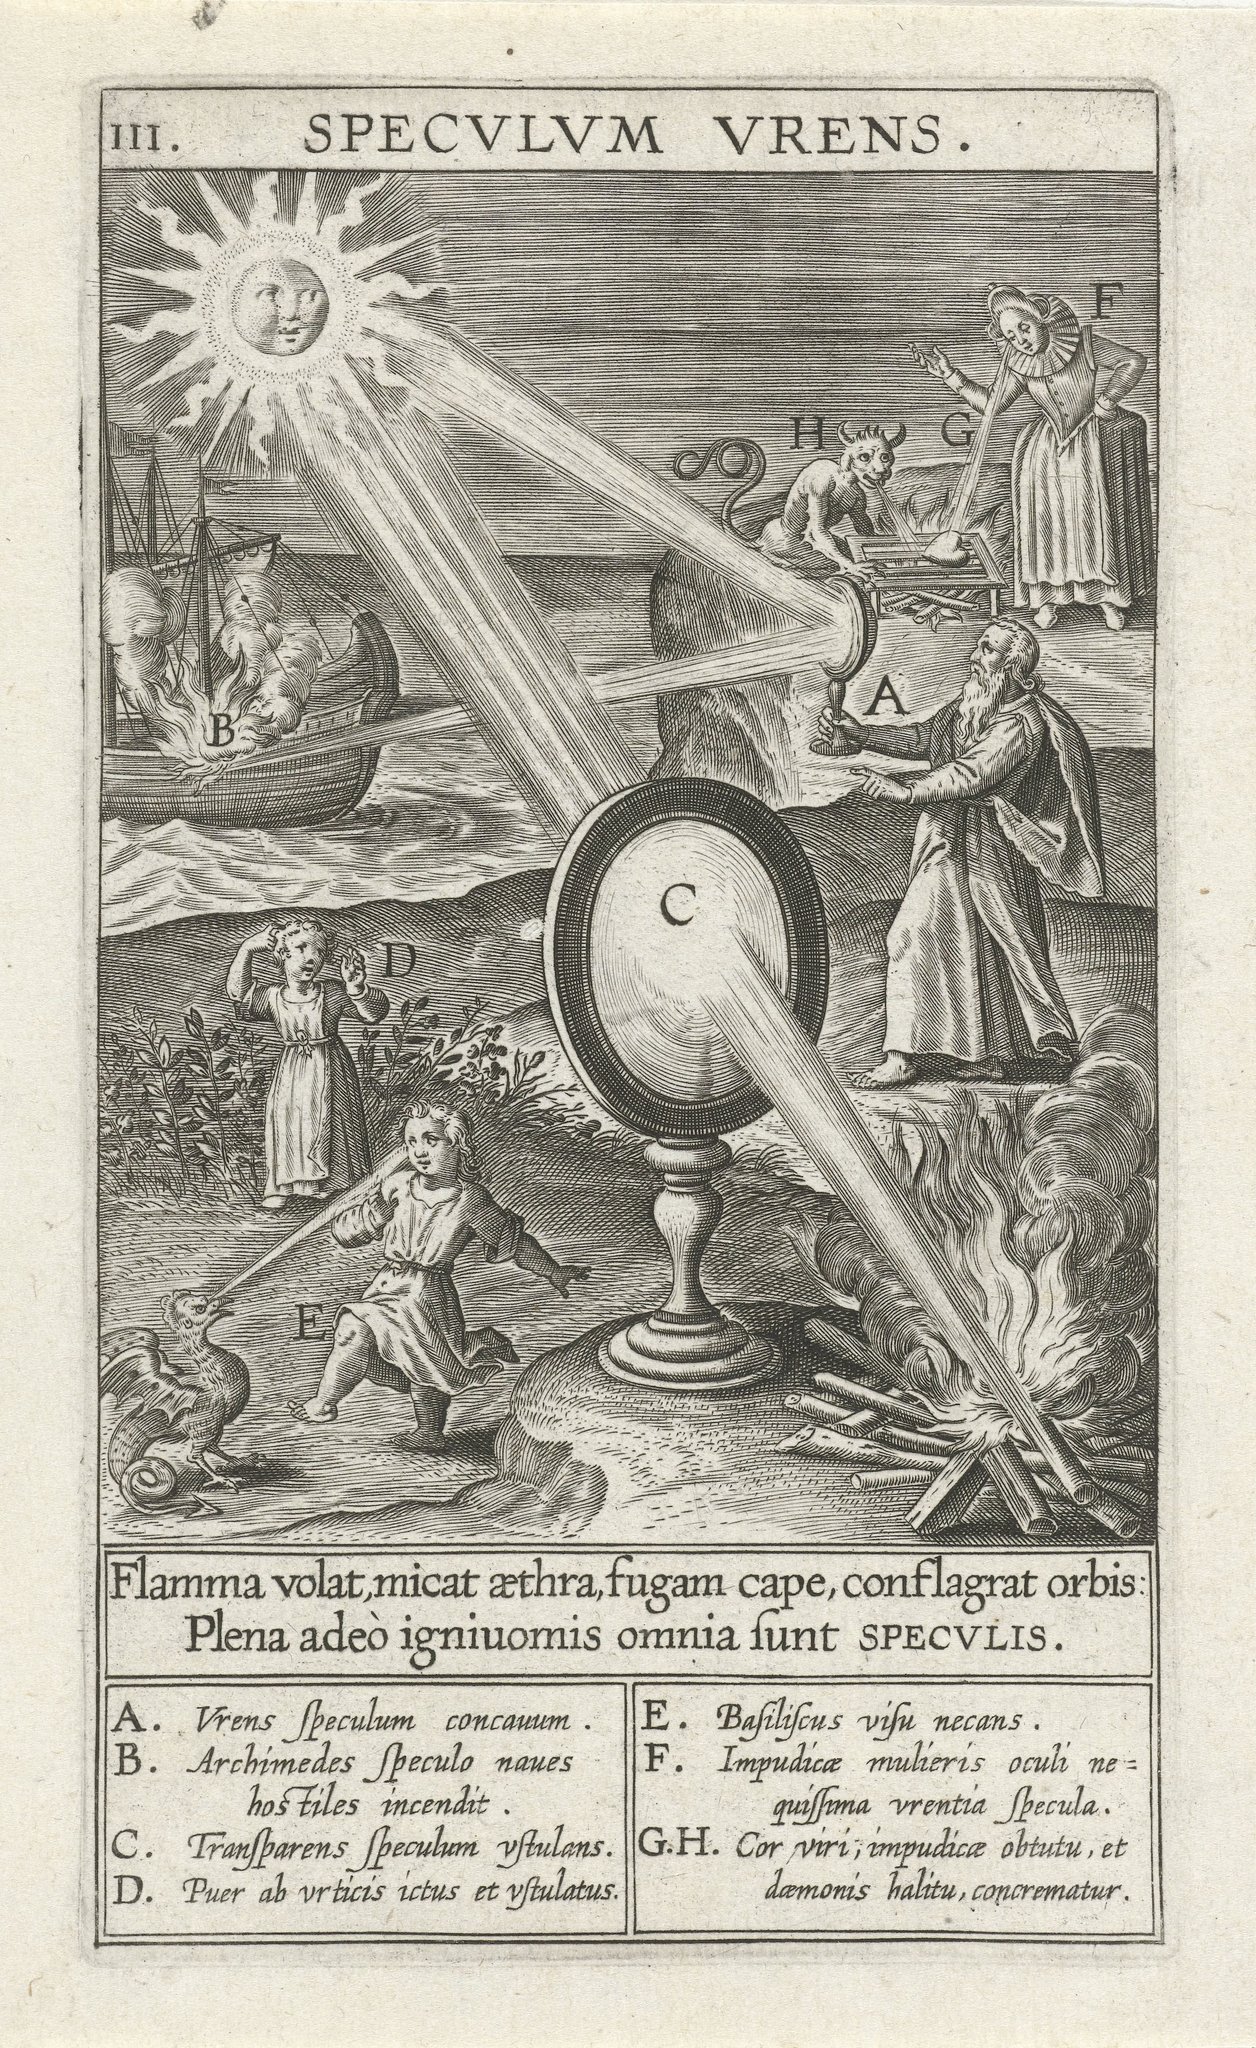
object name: print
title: Twaalf spiegels waarmee de mens God probeert te zien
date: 1610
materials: paper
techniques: engraving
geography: antwerp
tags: mirror, open fire (in general), basilisk (cock with posterior of snake), plants and herbs: stinging-nettle, concave mirror, burning-mirror, (story of) archimedes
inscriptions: collector's mark: Lugt 2228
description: Op de voorgrond wordt een vuur aangestoken door middel van het brandpunt van een spiegel. In de achtergrond toonbeelden van het gebruik van spiegels om vuur te maken: een kind wordt versteend door een basilisk, een kind wordt door brandnetels geprikt, Archimedes gebruikt een spiegel om een schip te doen branden. De prent heeft een Latijns onderschrift: 'Flamma volat, micat fugam cape, conflagrat orbis: plena adeo igniuomis omnia funt specvlis'. Onderaan een legende van de scènes die op de afbeelding alfabetisch genummerd zijn. De prent is deel van een twaalfdelige serie (III uit XII prenten) met als onderwerp twaalf spiegels waarmee de mens God probeert te zien.